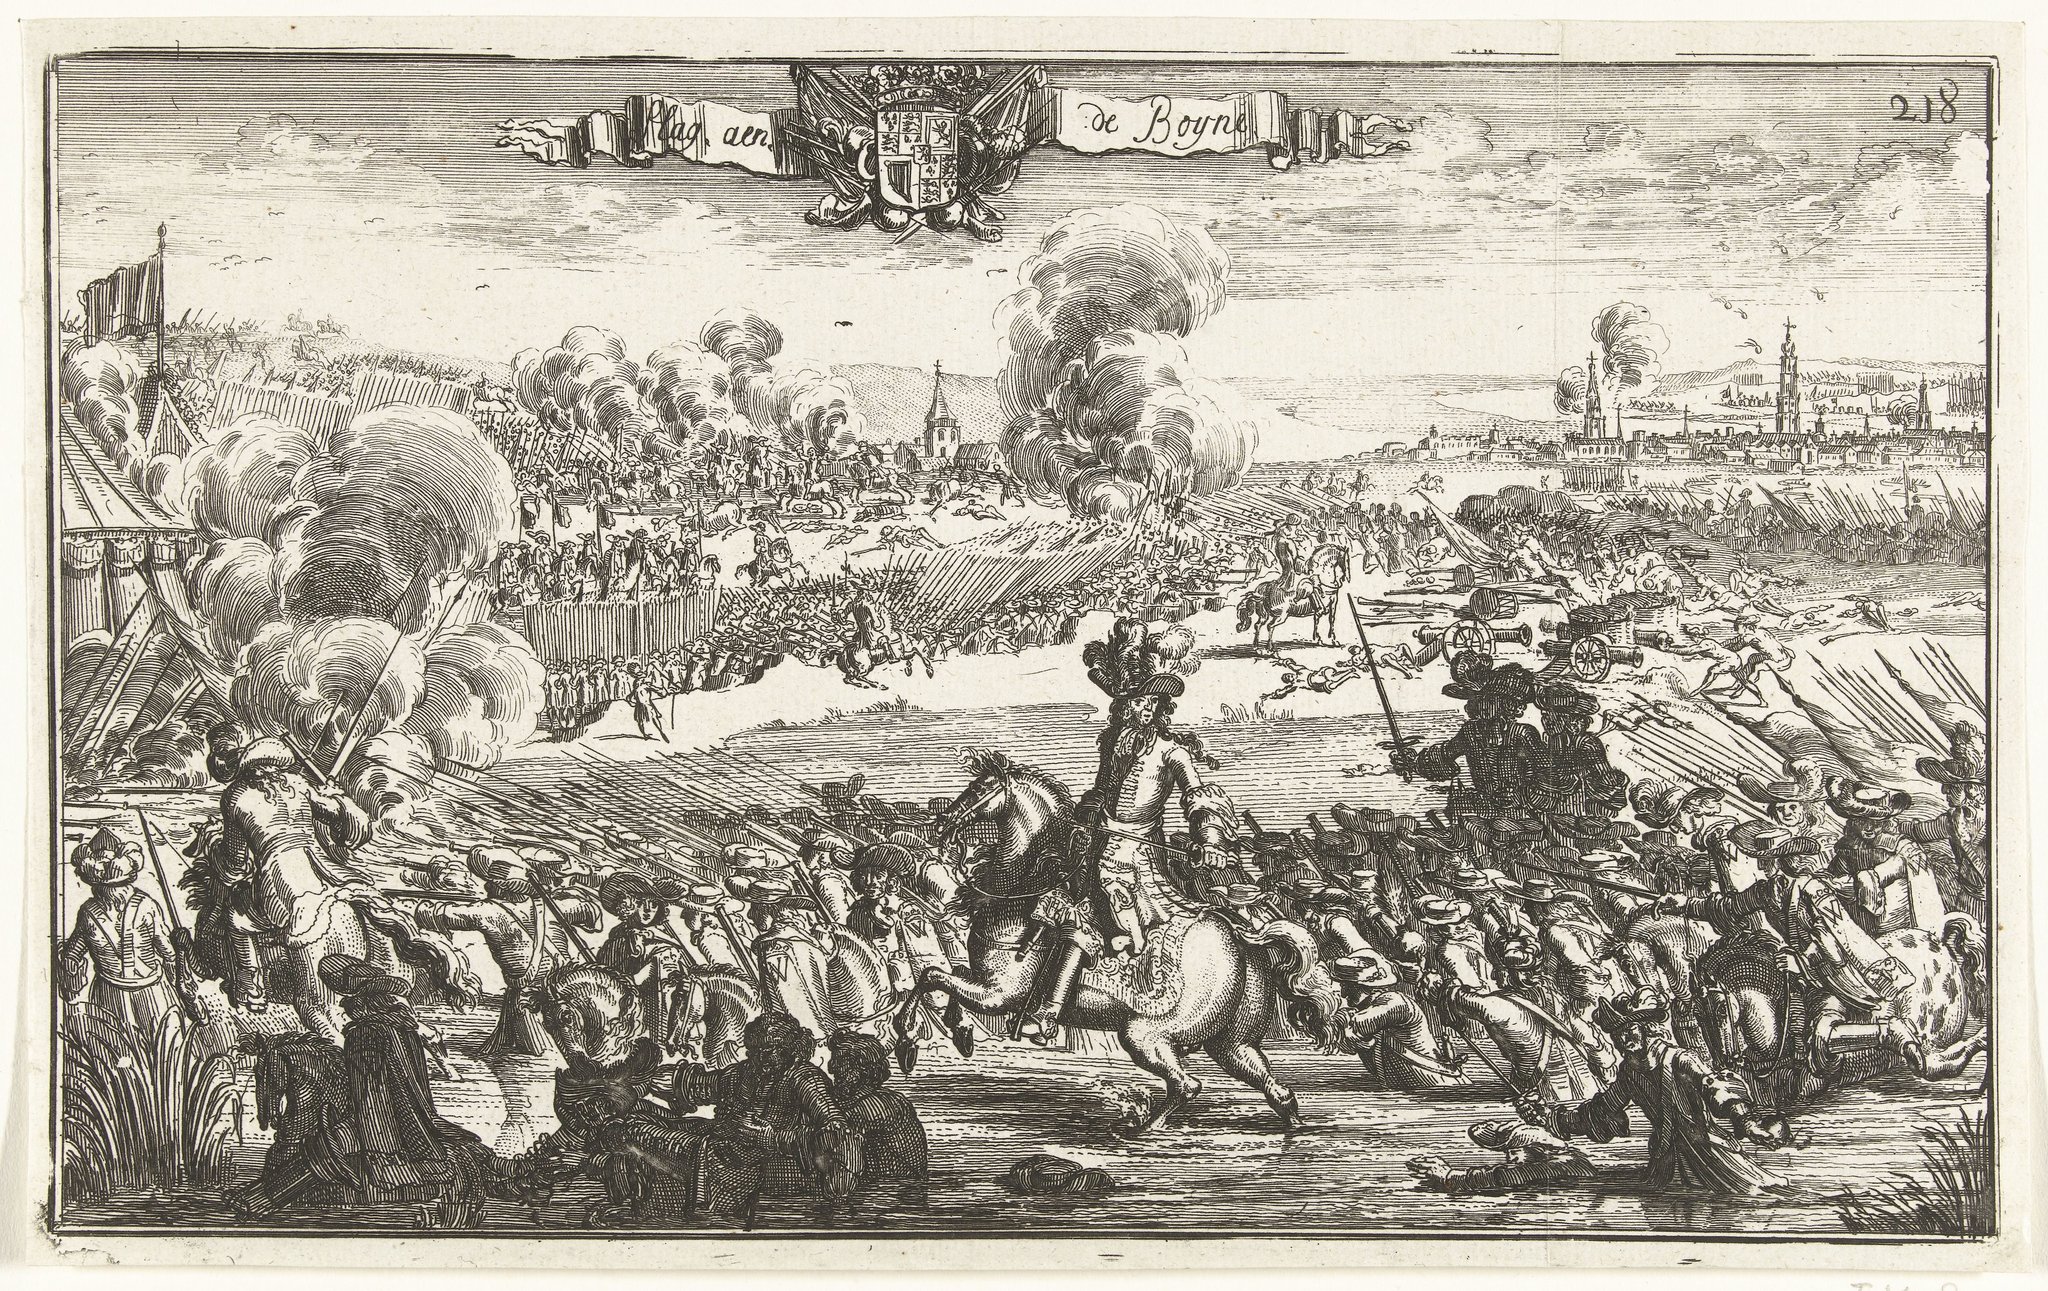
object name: print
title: Slag aen de Boyne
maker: Anonymous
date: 1690-1691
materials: paper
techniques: etching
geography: northern netherlands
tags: william iii (prince of orange and king of england, scotland, and ireland), battle (+ land forces)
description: Slag bij de rivier de Boyne op 11 juli 1690, waarbij het leger van Willem III en overwinning behaalt op de katholieken onder Jacobus II. Centraal waadt het leger met de koning te paard door de rivier. Genummerd rechtsboven: 218.